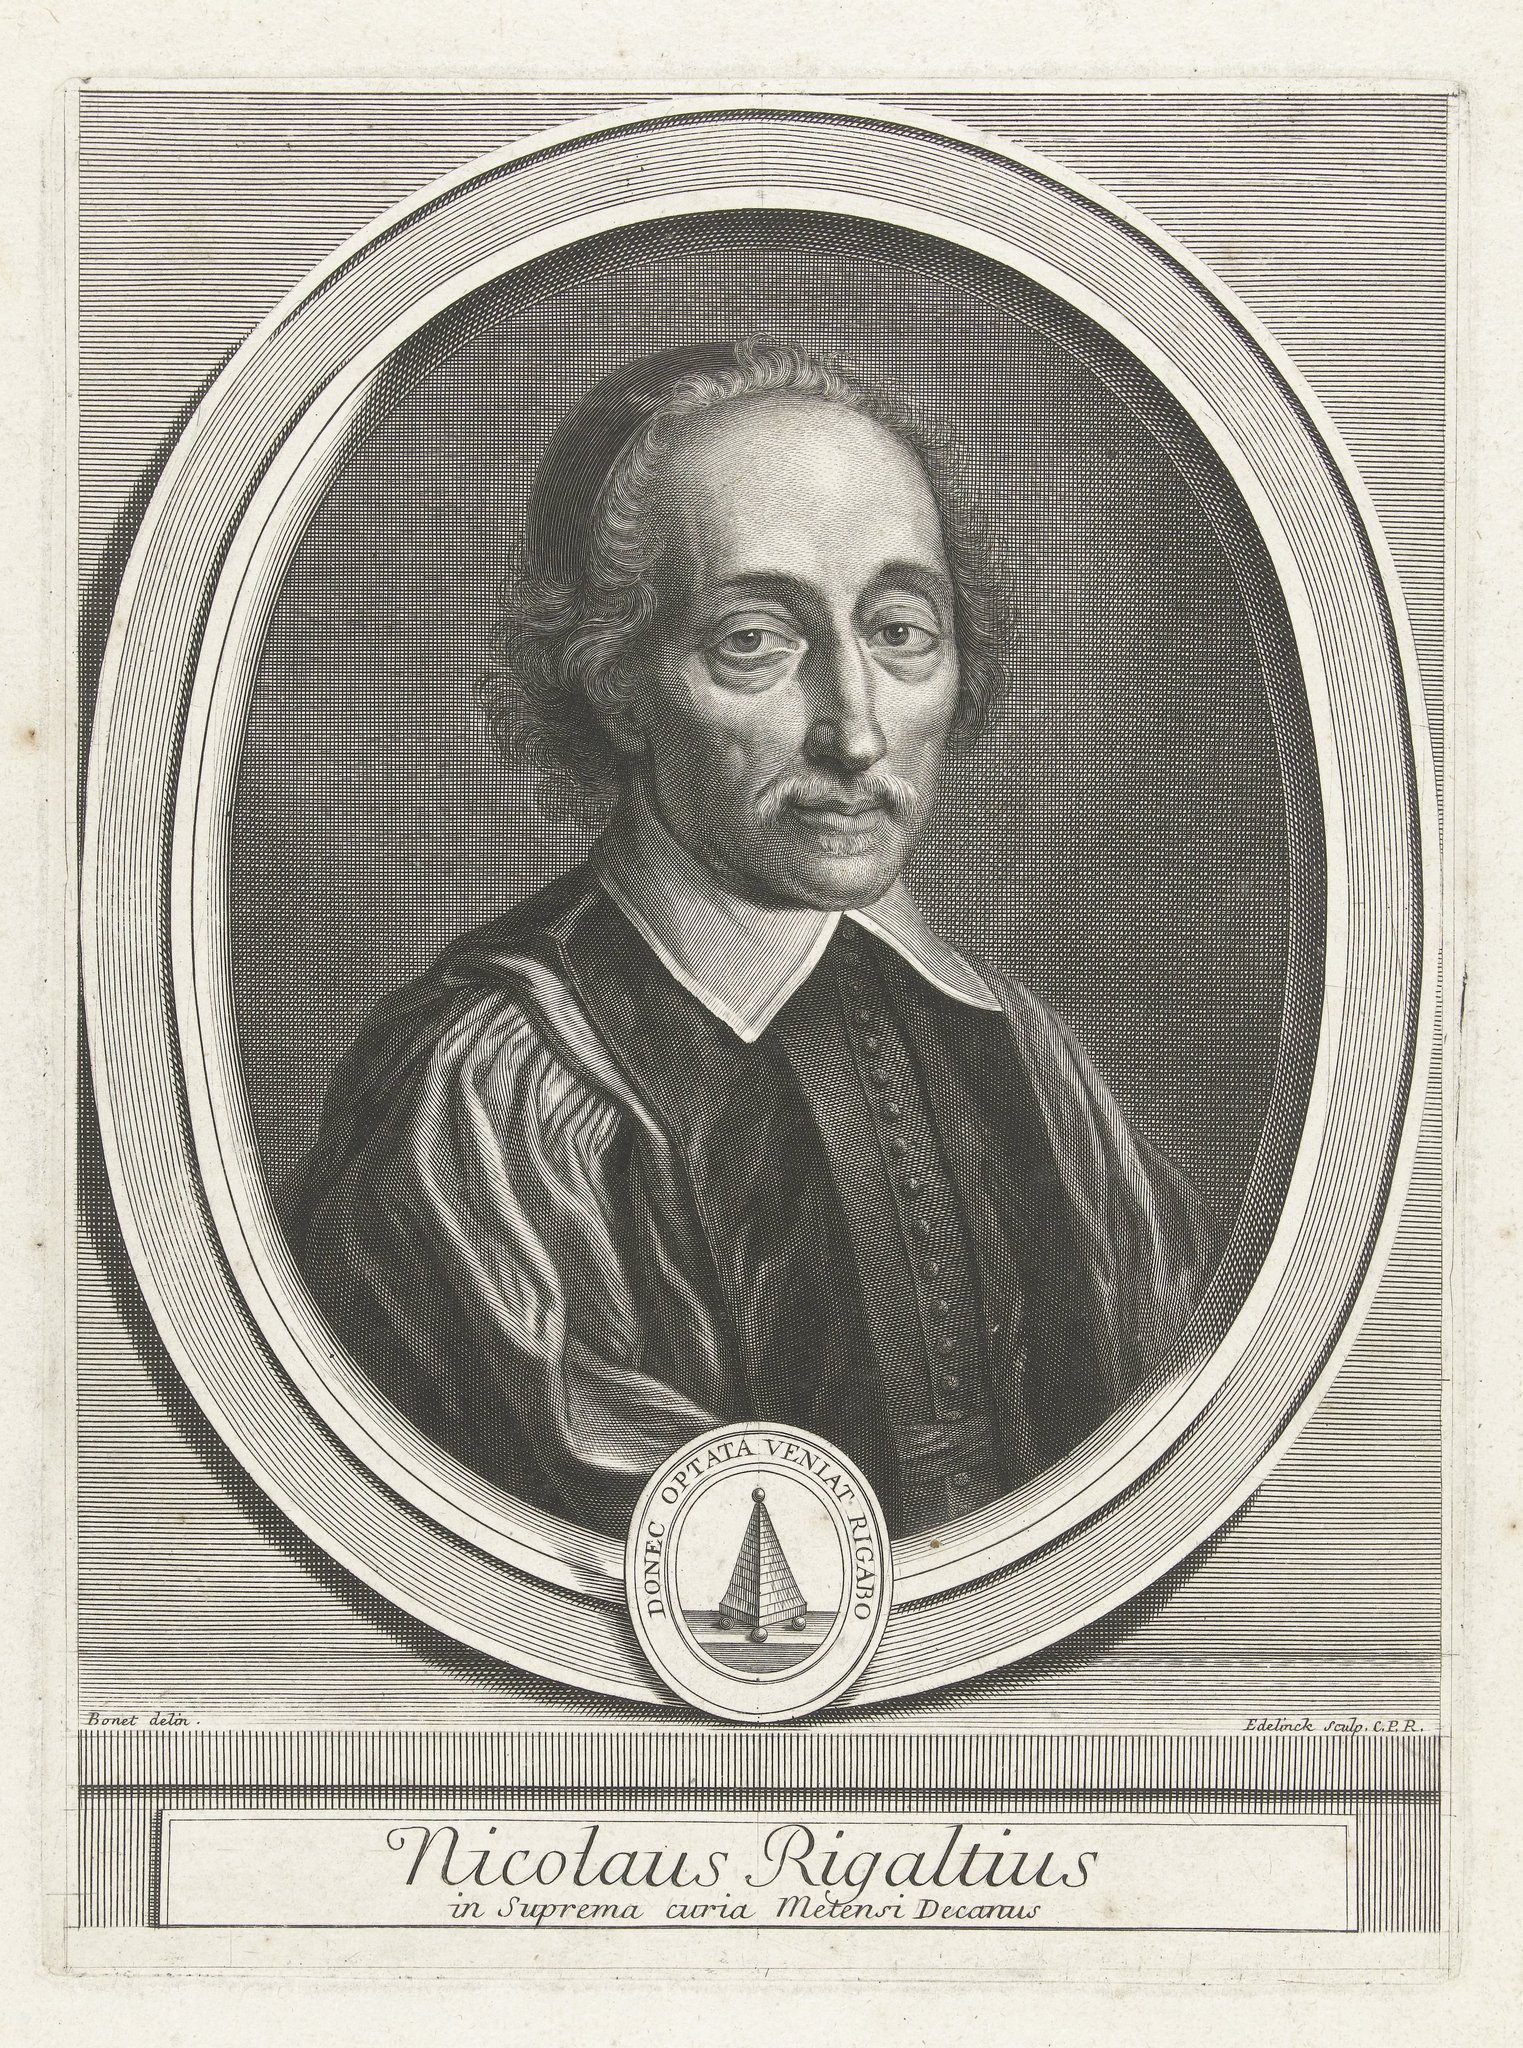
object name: print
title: Portret van Nicolas Rigault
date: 1666-1707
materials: paper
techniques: engraving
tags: paris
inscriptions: collector's mark: Lugt 240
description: Portret van de Franse filoloog Nicolas Rigault (1577-1654), afgebeeld in ovale omlijsting met ovaal embleem.